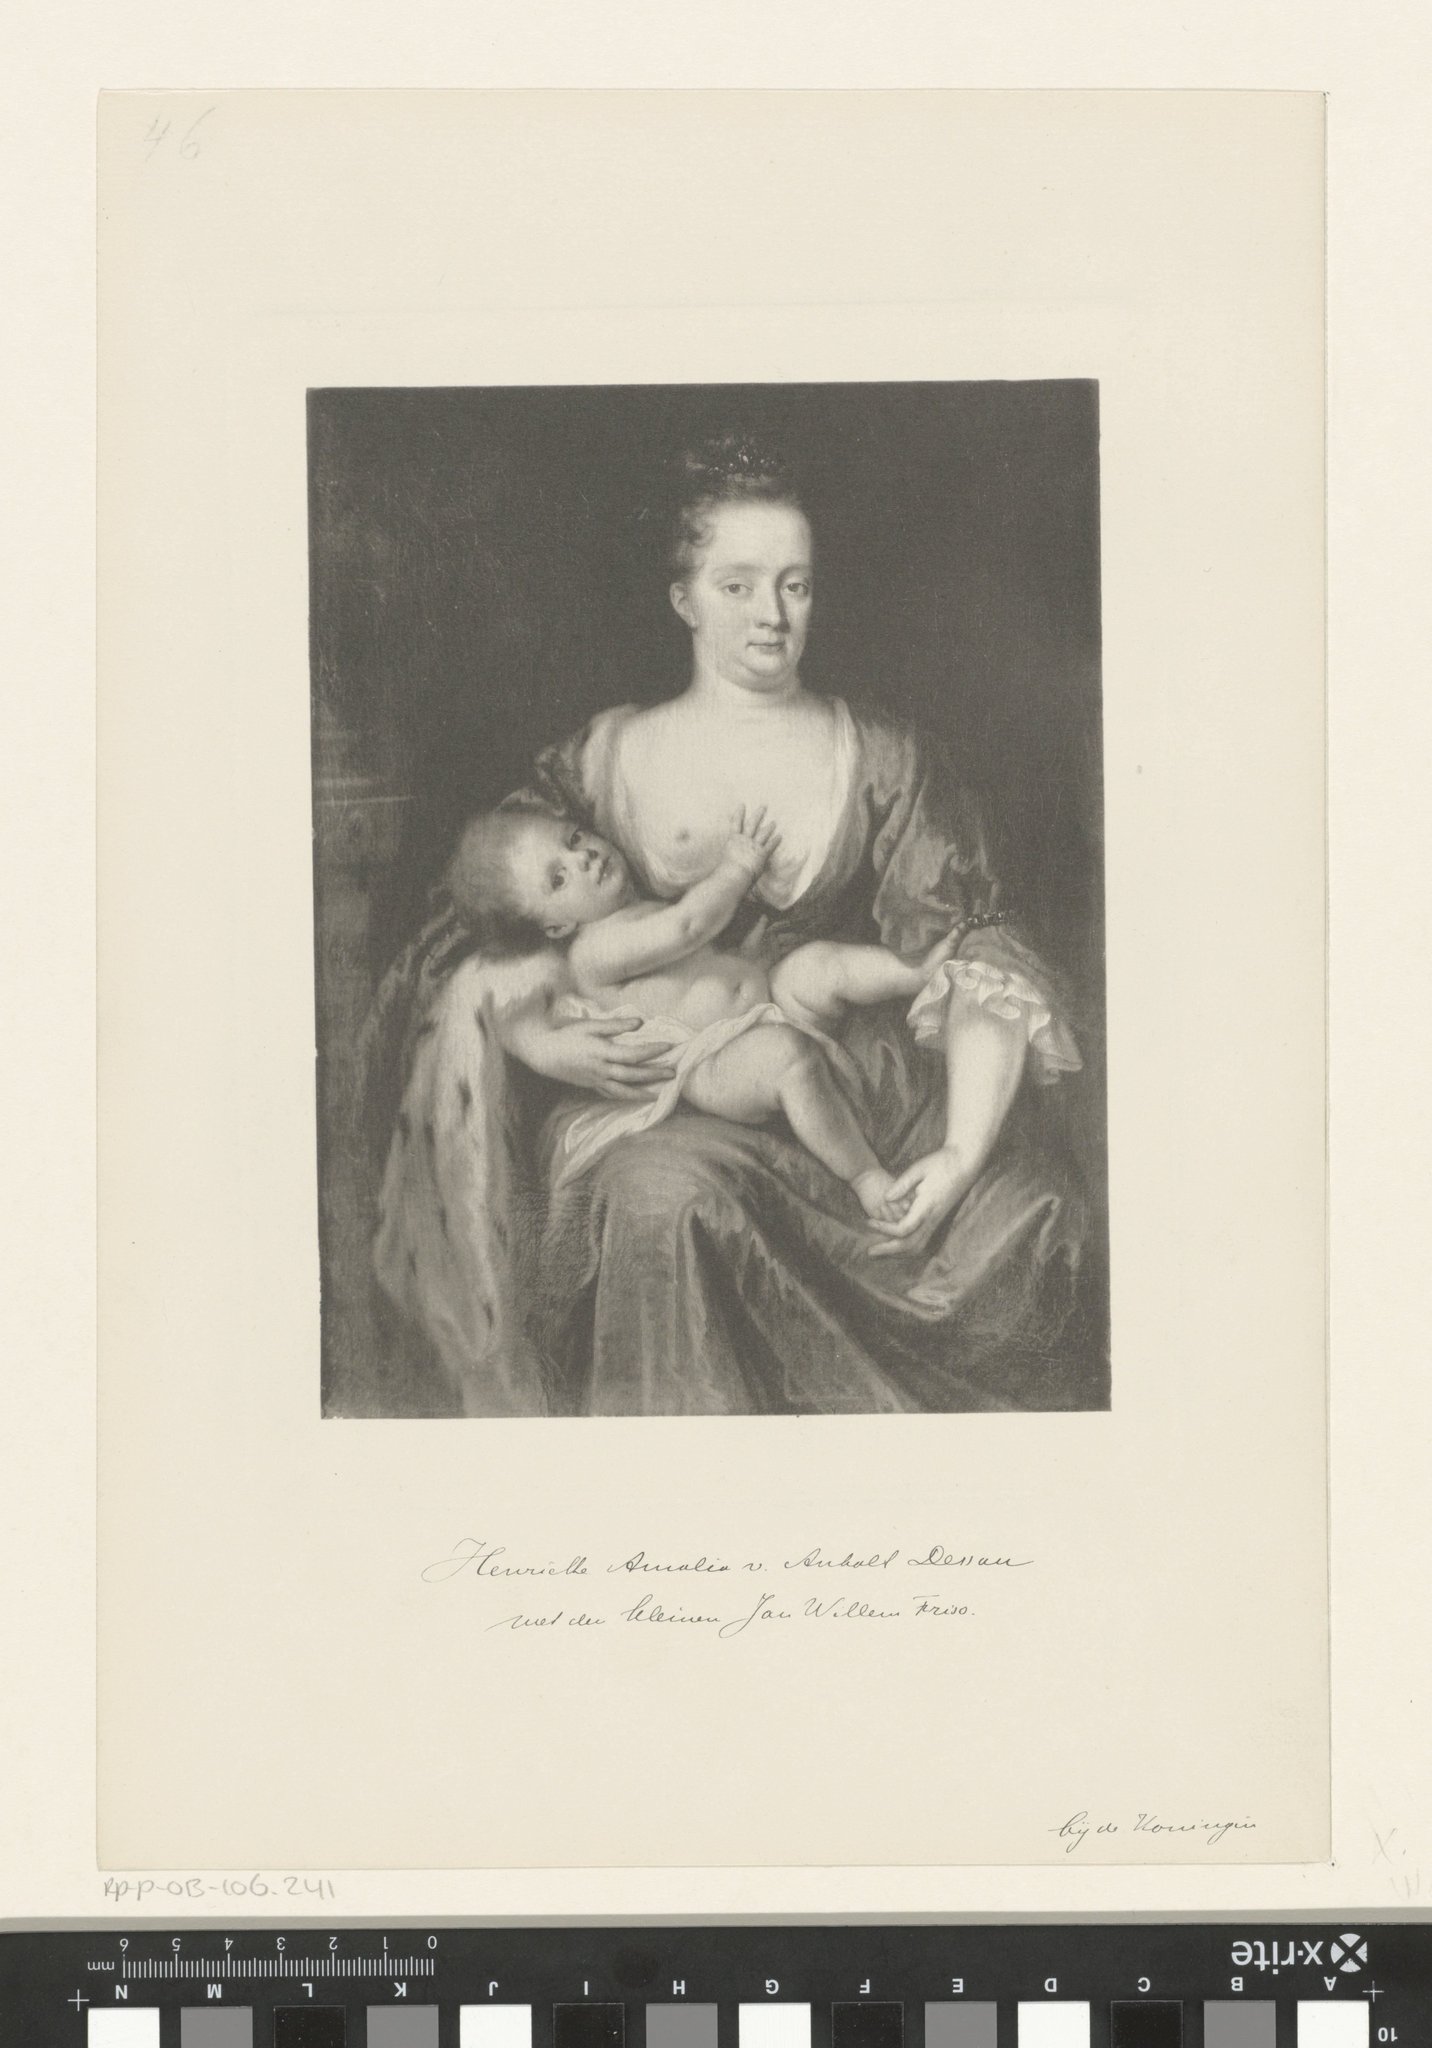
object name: photomechanical print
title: Portret van Henriëtte Amalia van Anhalt-Dessau en Henriëtte Casimira, gravin van Nassau-Dietz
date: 1850-1949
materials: paper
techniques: photograph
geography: netherlands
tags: leeuwarden, oranienstein, schloss, henriëtte casimira gravin van nassau-dietz, henriëtte amalia van anhalt-dessau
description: De hier vermelde titel verwijst naar de hoogst verkregen titel van de geportretteerde, niet per se naar de titel die de geportretteerde op deze voorstelling draagt.